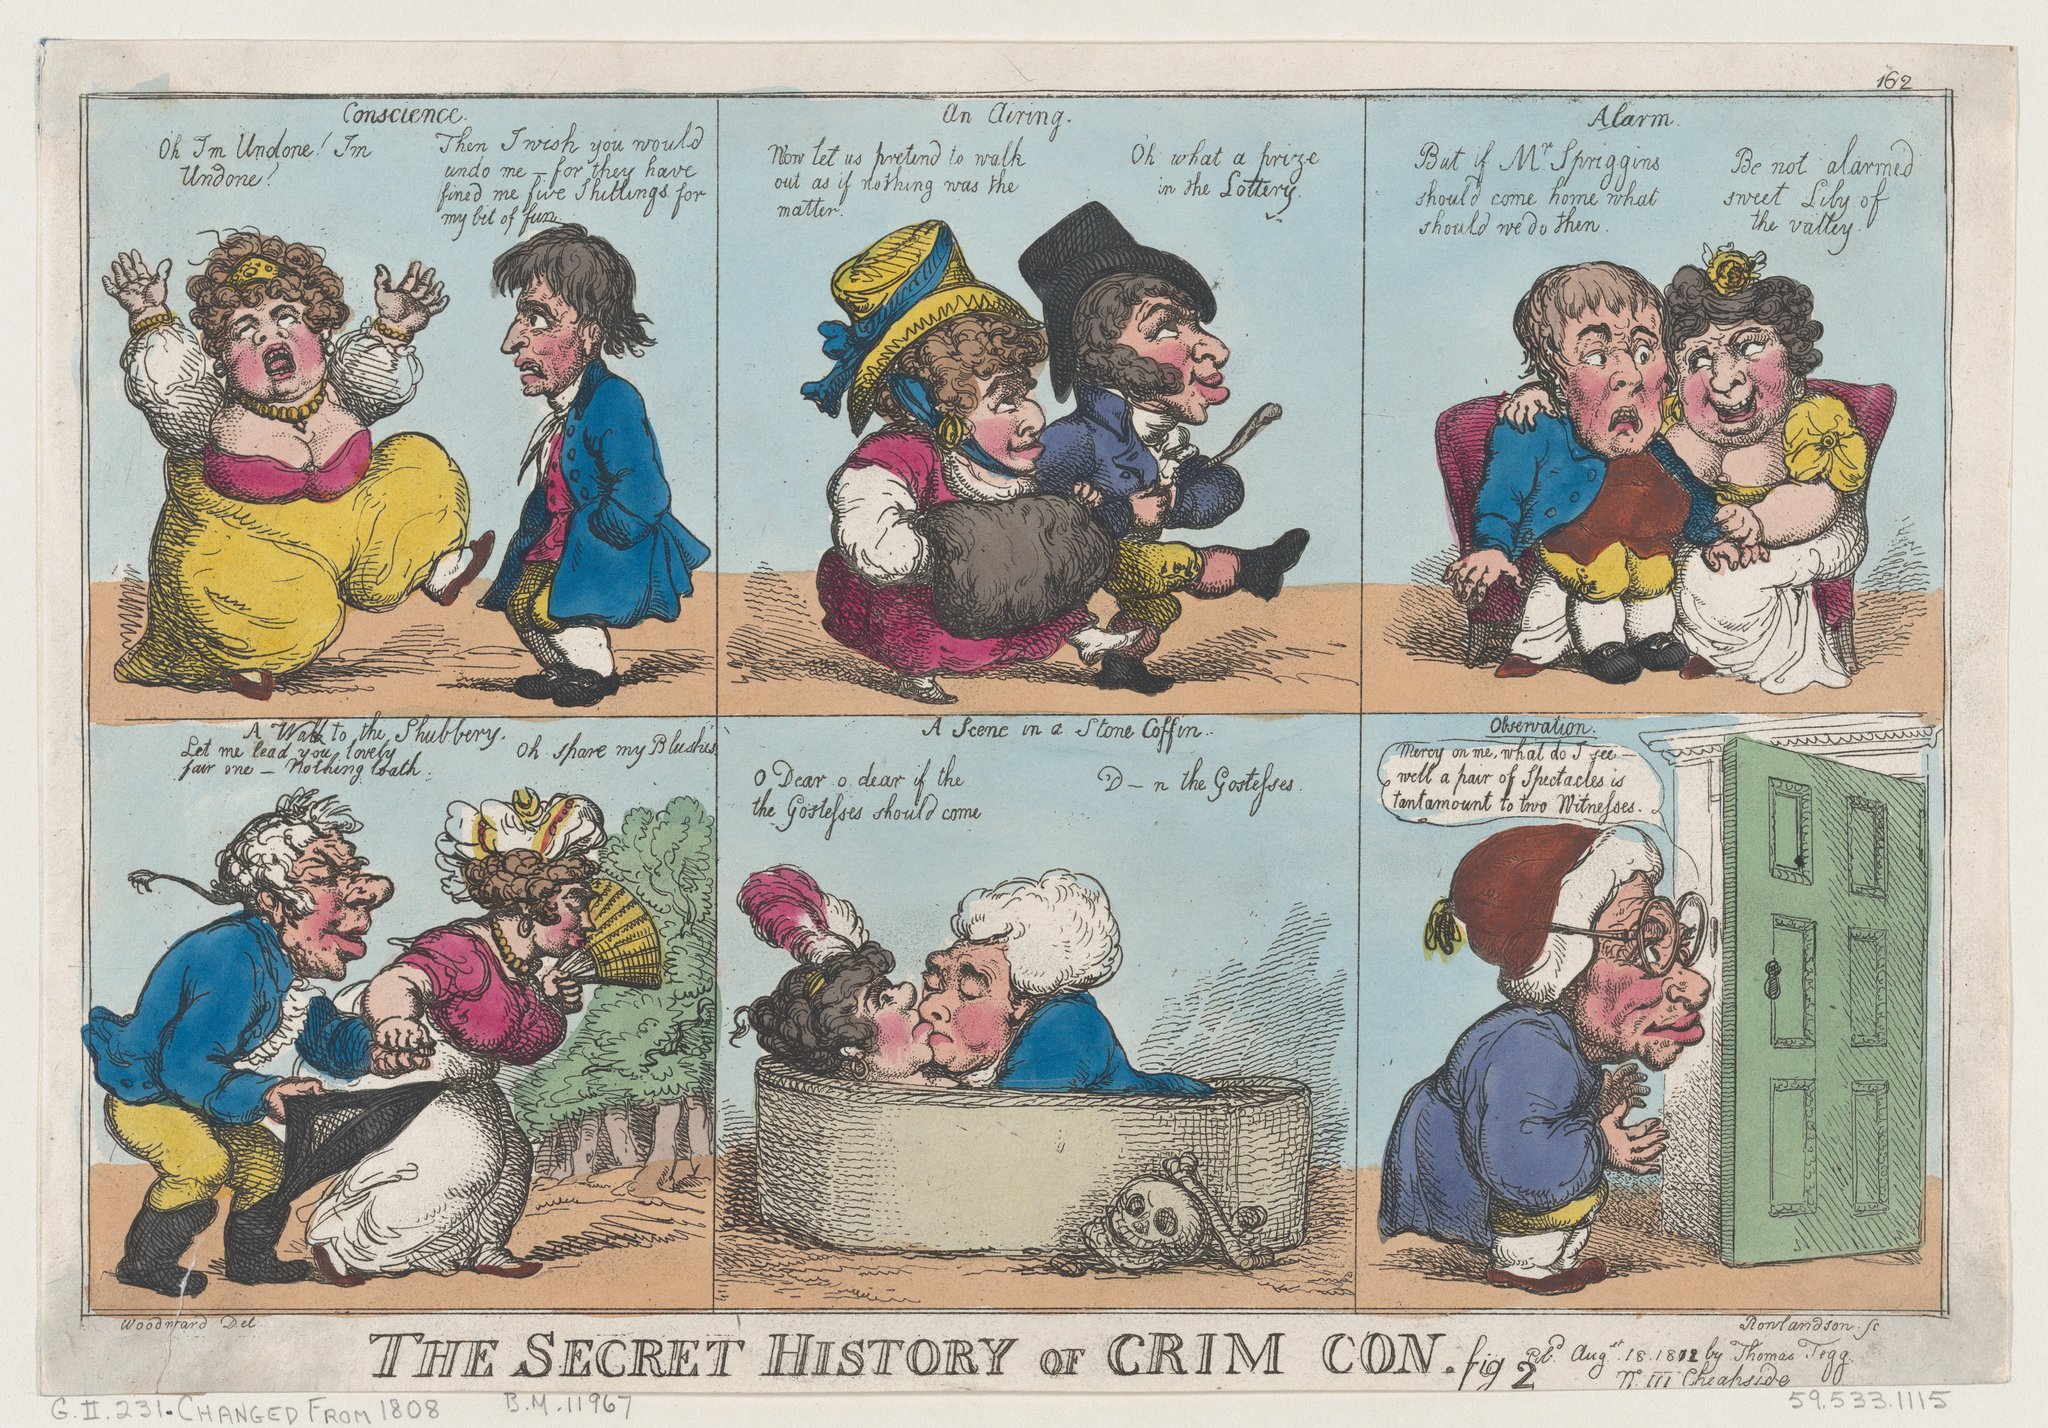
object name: print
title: The Secret History of Crim Con, Fig. 2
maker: thomas rowlandson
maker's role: artist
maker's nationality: british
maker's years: 1757-1827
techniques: etching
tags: satire,men,women